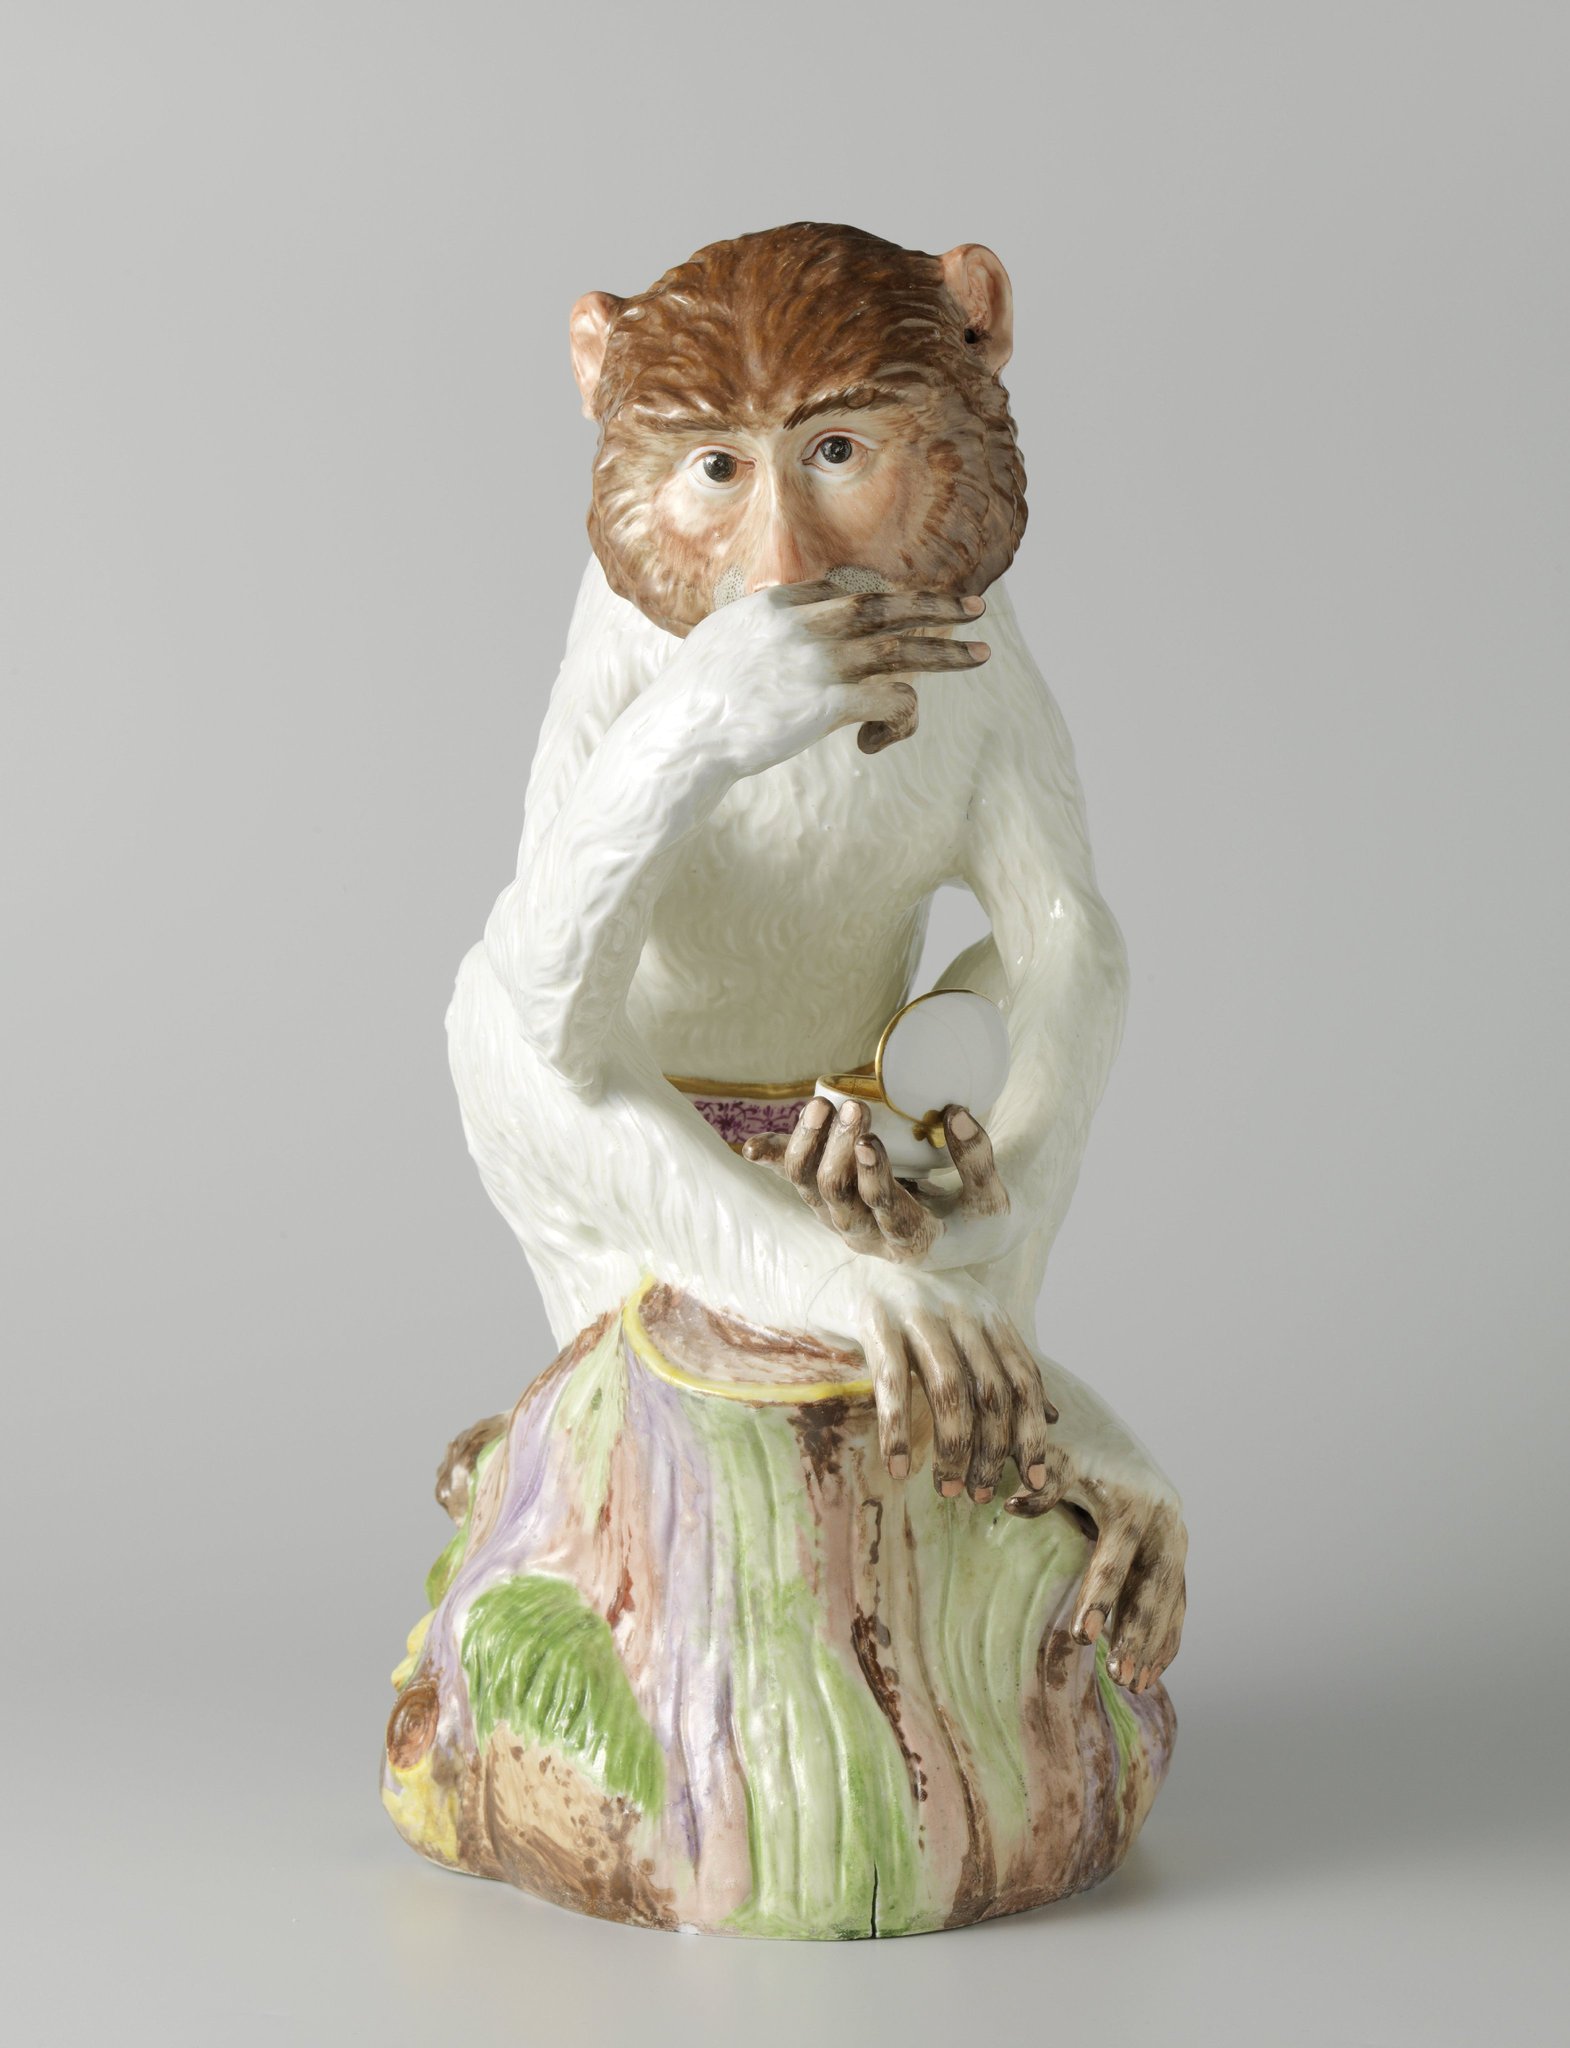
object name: figure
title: Monkey with a snuffbox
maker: johann joachim kändler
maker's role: designer, sculptor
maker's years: 1706-1775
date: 1730-1733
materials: porcelain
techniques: painted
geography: meissen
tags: snuff-box, monkeys, apes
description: The porcelain factory at Meissen, near Dresden, was founded in 1709. It was the first European factory to produce ‘true’ or hard-paste porcelain, like that known in China and Japan. The manufactory was owned by Augustus the Strong, Elector of Saxony and King of Poland. All the birds and animals in this display case were made for him. They were intended for his so-called Japanese Palace, the walls of which he wished to fill with porcelain.